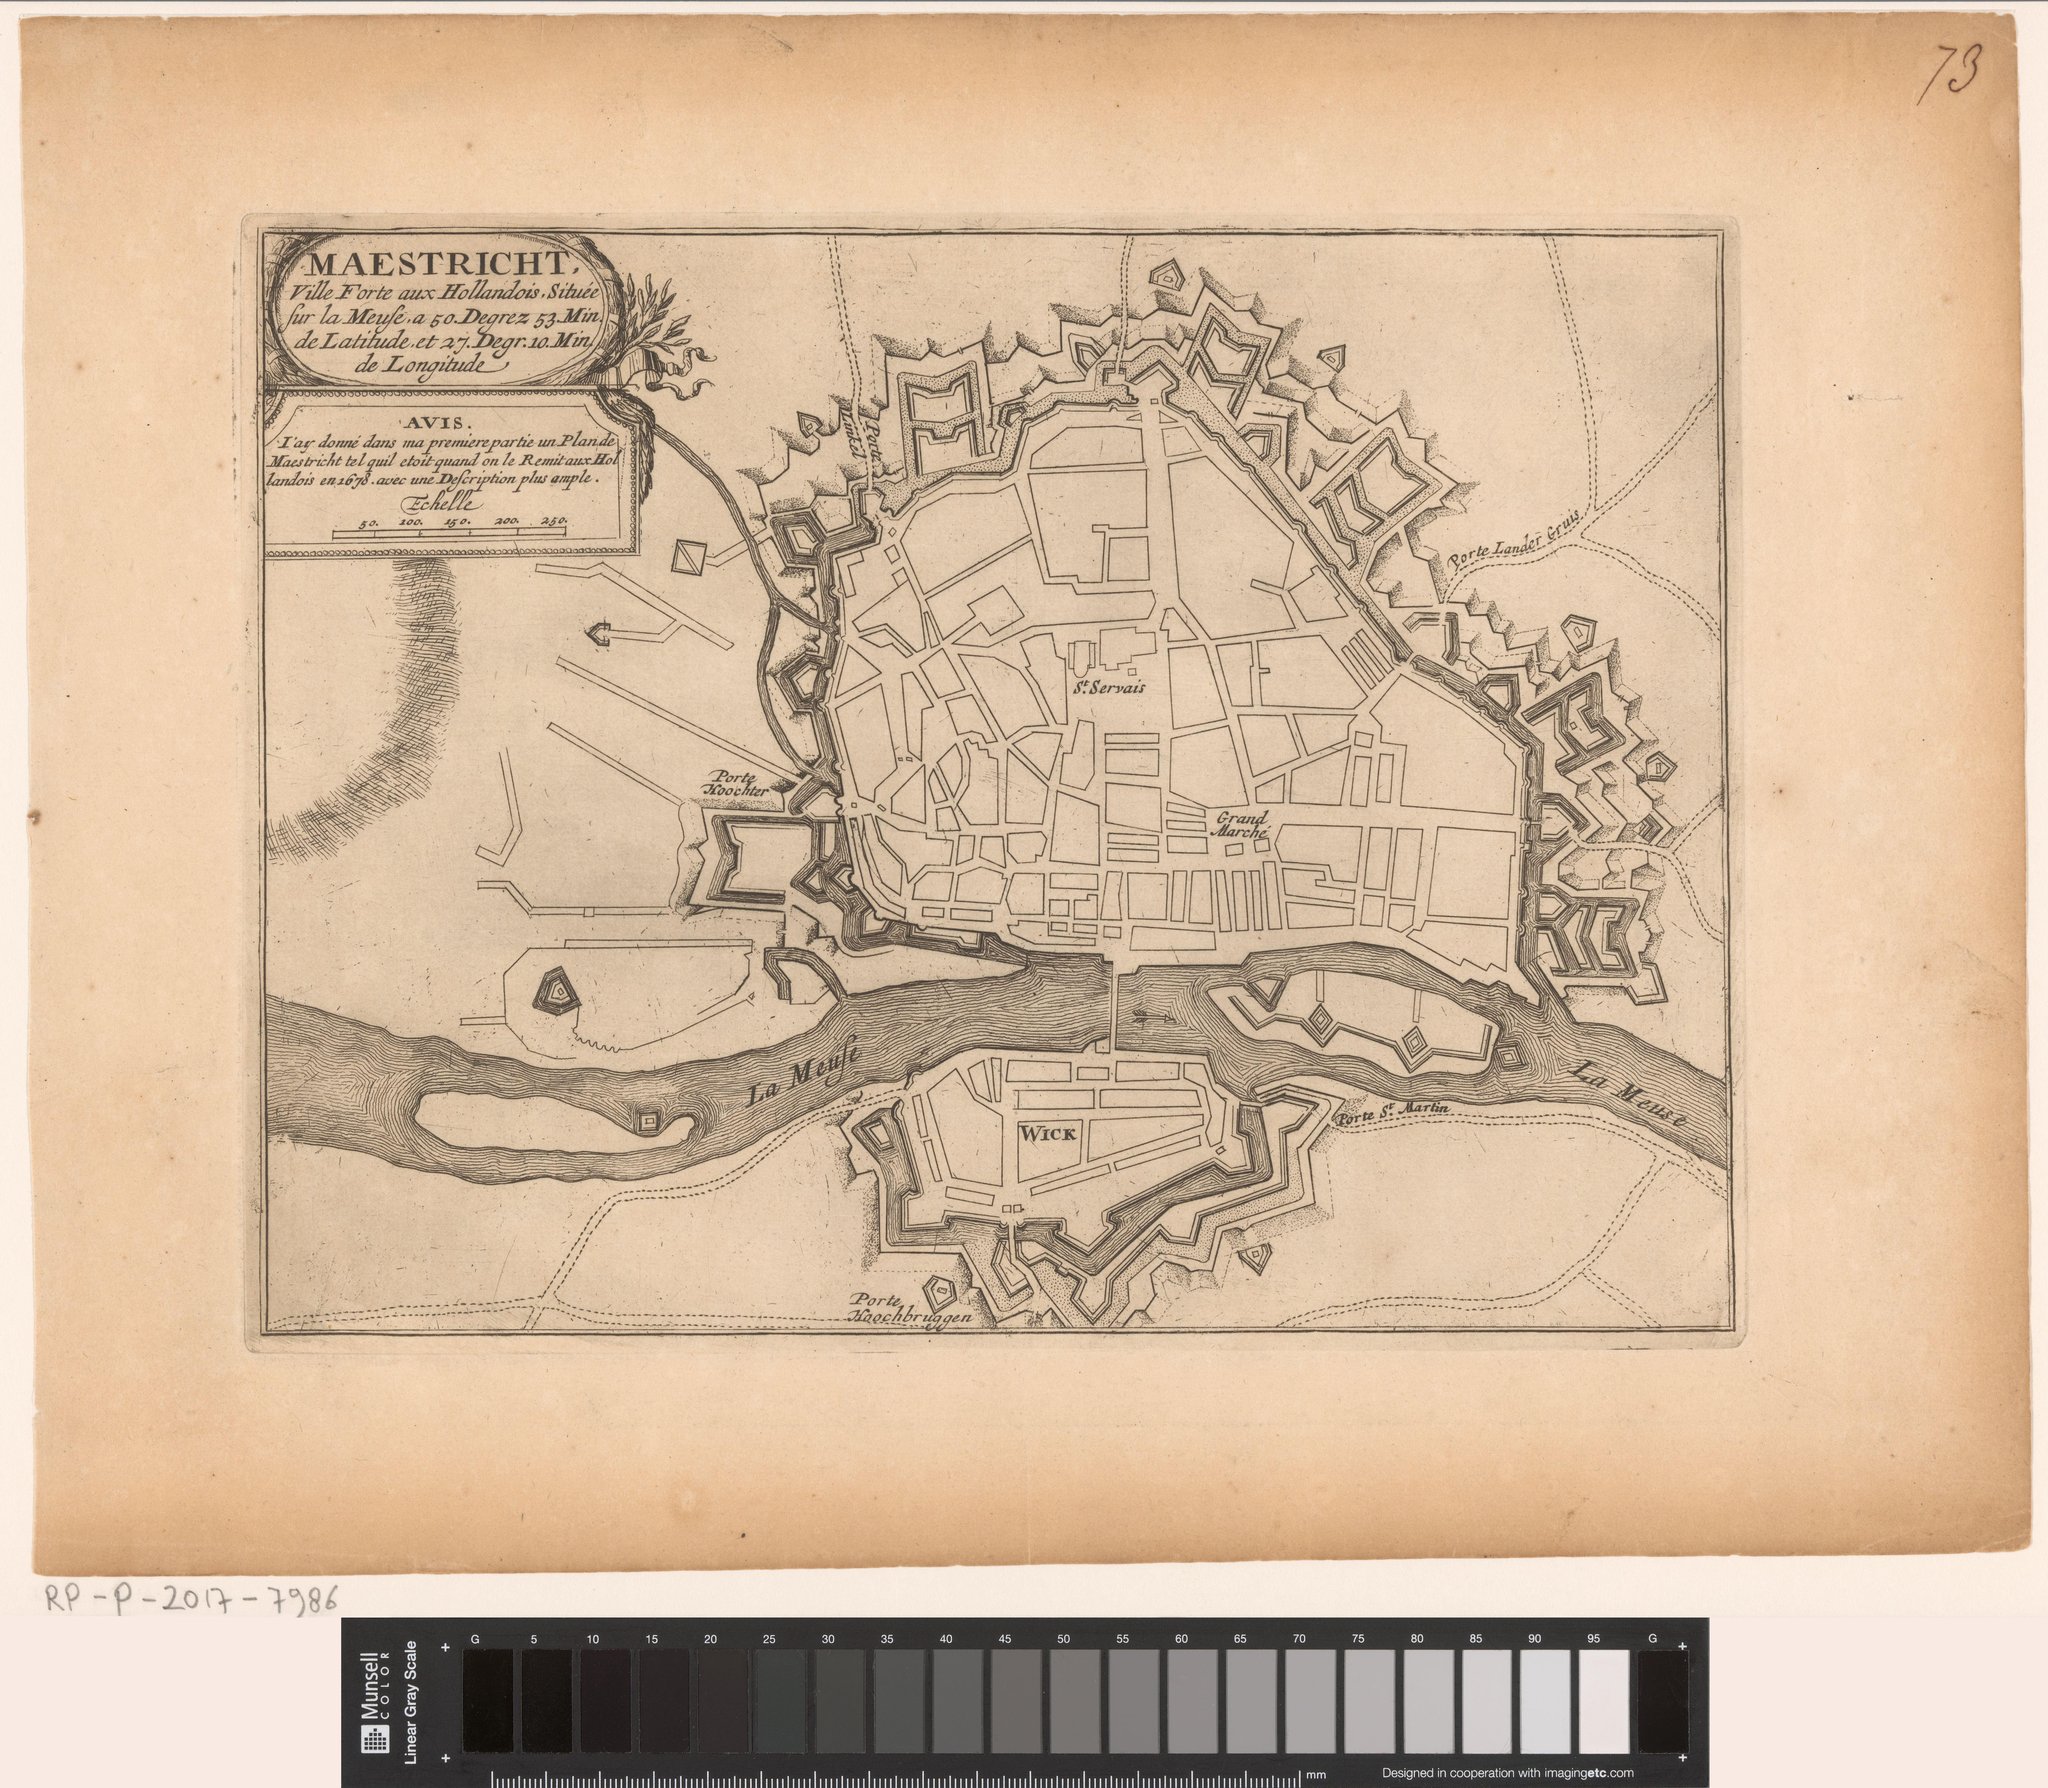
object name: area plan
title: Maestricht, Ville Forte aux Hollandois, Située sur la Meuse (...)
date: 1690-1697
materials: paper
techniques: engraving, etching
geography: paris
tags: maps of cities, maastricht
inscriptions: collector's mark: Lugt 2228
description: Prent in huidige staat ook gebruikt in: Fer, Nicolas de. Les forces de l'Europe, ou description des principales villes, avec leurs fortifications : dessignées par les meilleurs ingenieurs, particulierement celles (…). Parijs: Nicolas de Fer, 1690-1695. En in: Fer, Nicolas de. Le theatre de la guerre, dans les Pays-Bas, ou representation des principales villes qui sont en Flander, Hainaut, Brabant (...). Parijs: Nicolas de Fer, 1697.